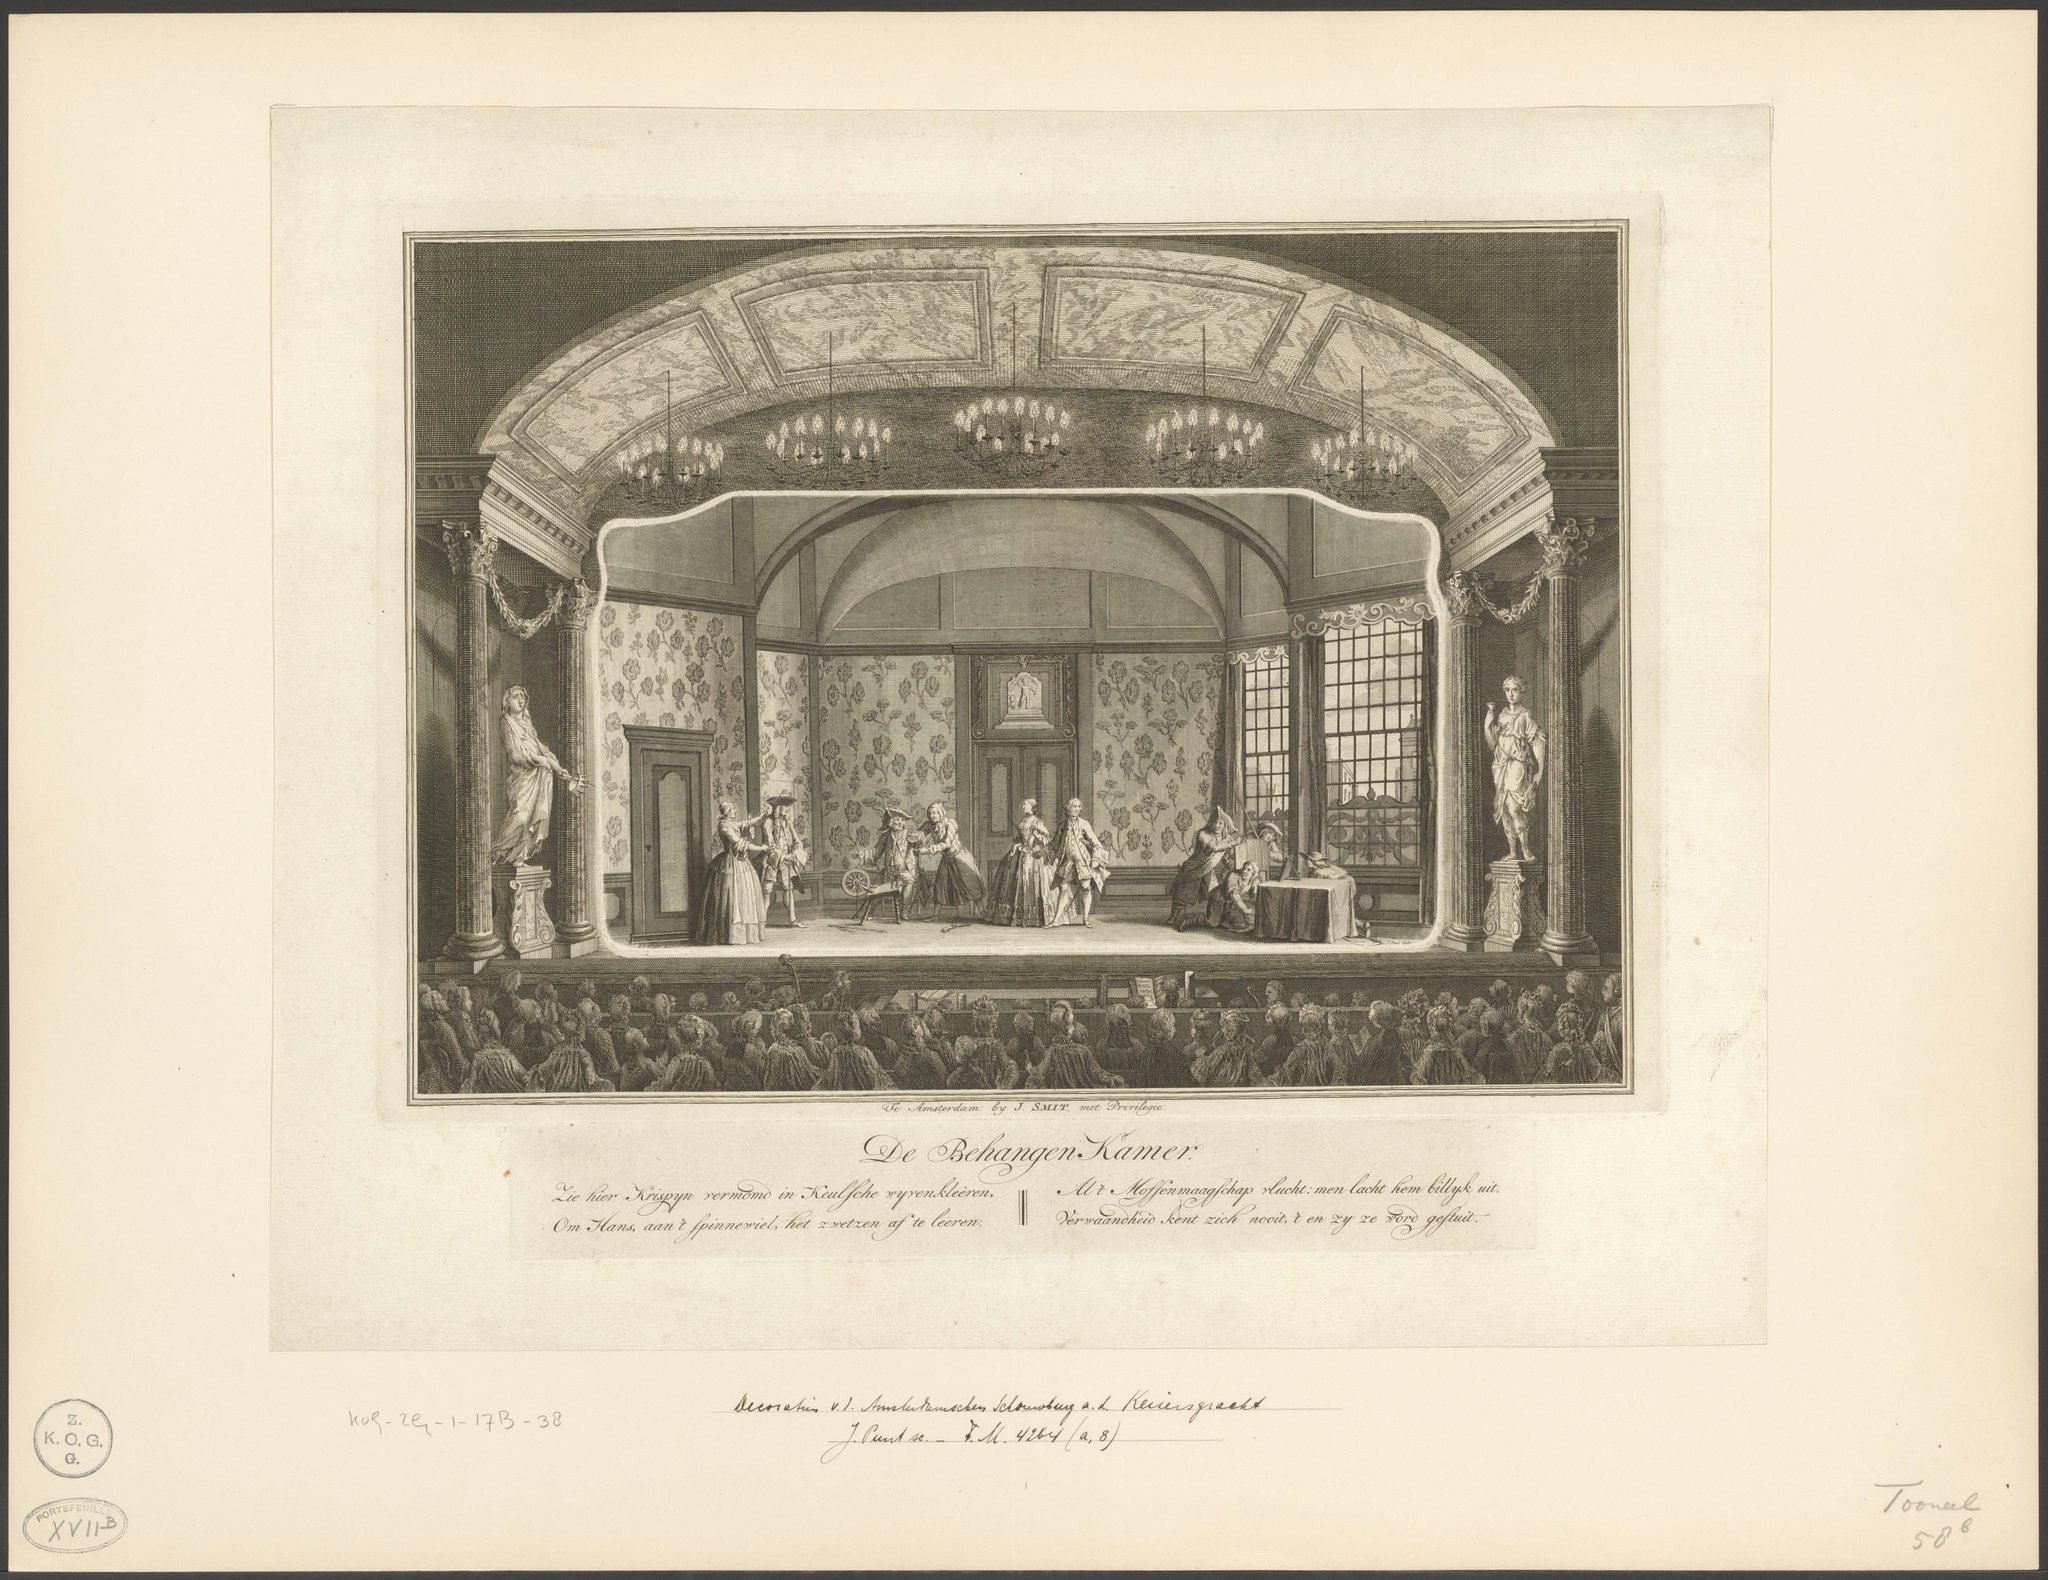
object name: print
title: Toneeldecors van de Amsterdamse Schouwburg, ca. 1770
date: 1736-1738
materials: paper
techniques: engraving, etching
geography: amsterdam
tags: theatre, theatrical performance, stage design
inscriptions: stamp, collector's mark: Lugt 1641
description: Toneelvoorstelling in de Amsterdamse Schouwburg op de Keizersgracht met het coulissendecor De Behangen Kamer met scène uit: De Zwetser. Het decor gedrukt van een aparte plaat binnen een passe-partout met de zaal, zijloges, orkestbak en de façade van het toneel met zuilen, guirlandes en kroonluchters. De titel en een vierregelig vers ook gedrukt van een aparte plaat. Onderdeel van een serie van twaalf toneeldecors. Onderwerpsrubrieken binnen de Atlas Zeden en Gewoonten: Schoone kunsten, Tooneel, Schouwburg op de Keizersgracht (1637 – 1772).